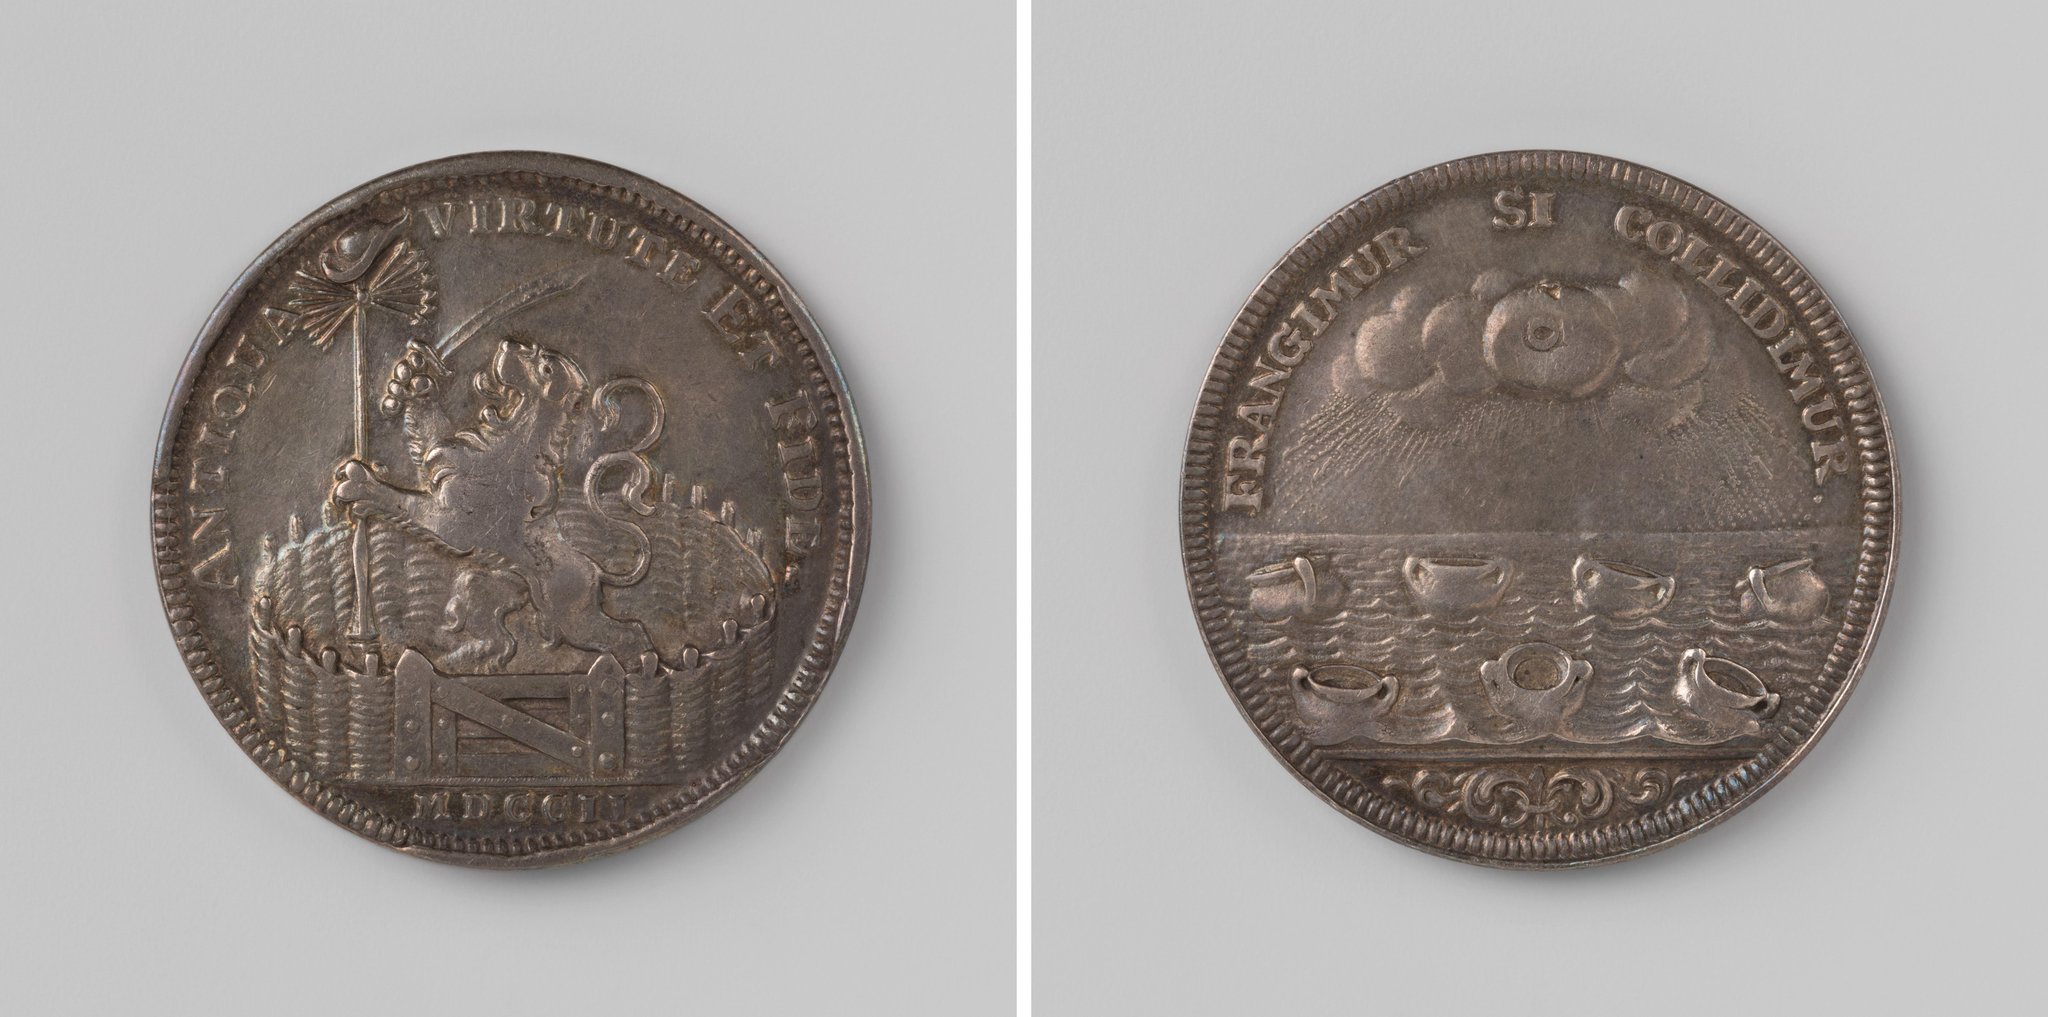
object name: history medal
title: Eendracht der Verenigde Provinciën bij de dood van Willem III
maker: Anonymous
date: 1702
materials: silver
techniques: striking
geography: netherlands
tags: william iii (prince of orange and king of england, scotland, and ireland)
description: Zilveren penning. Voorzijde: leeuw met zwaard en speer met daaraan pijlenbundel en vrijheidshoed binnen gesloten omheining, binnen omschrift. Keerzijde: zeven potten drijvend op zee, terwijl zwaar onweer drijgt binnen omschrift.